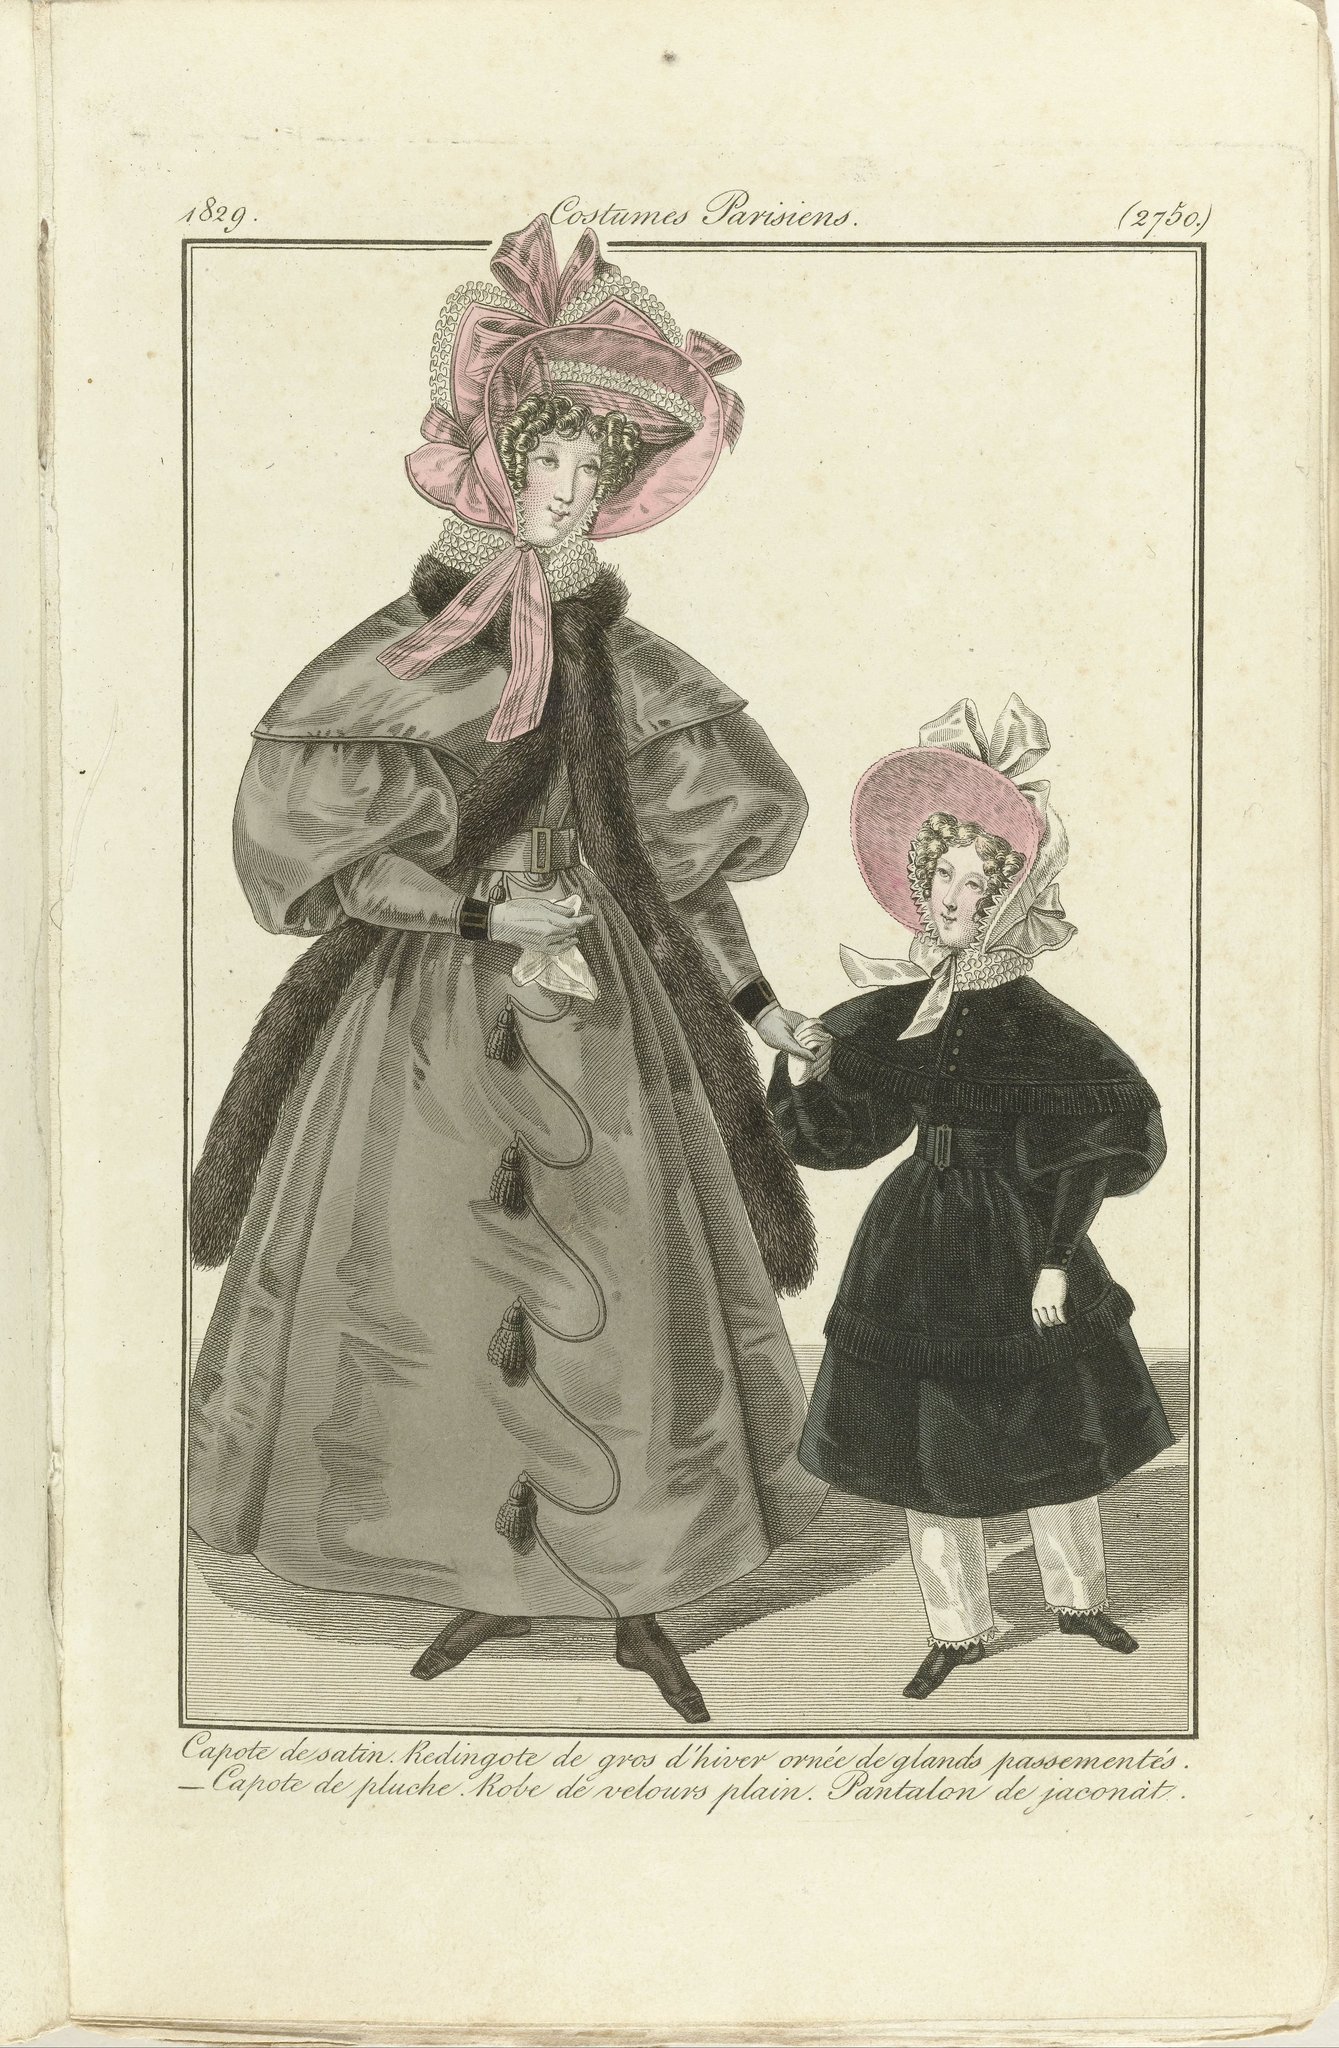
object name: fashion print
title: Journal des Dames et des Modes 1829, Costumes Parisiens (2750)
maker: Anonymous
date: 1829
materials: paper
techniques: etching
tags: fashion plates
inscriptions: date